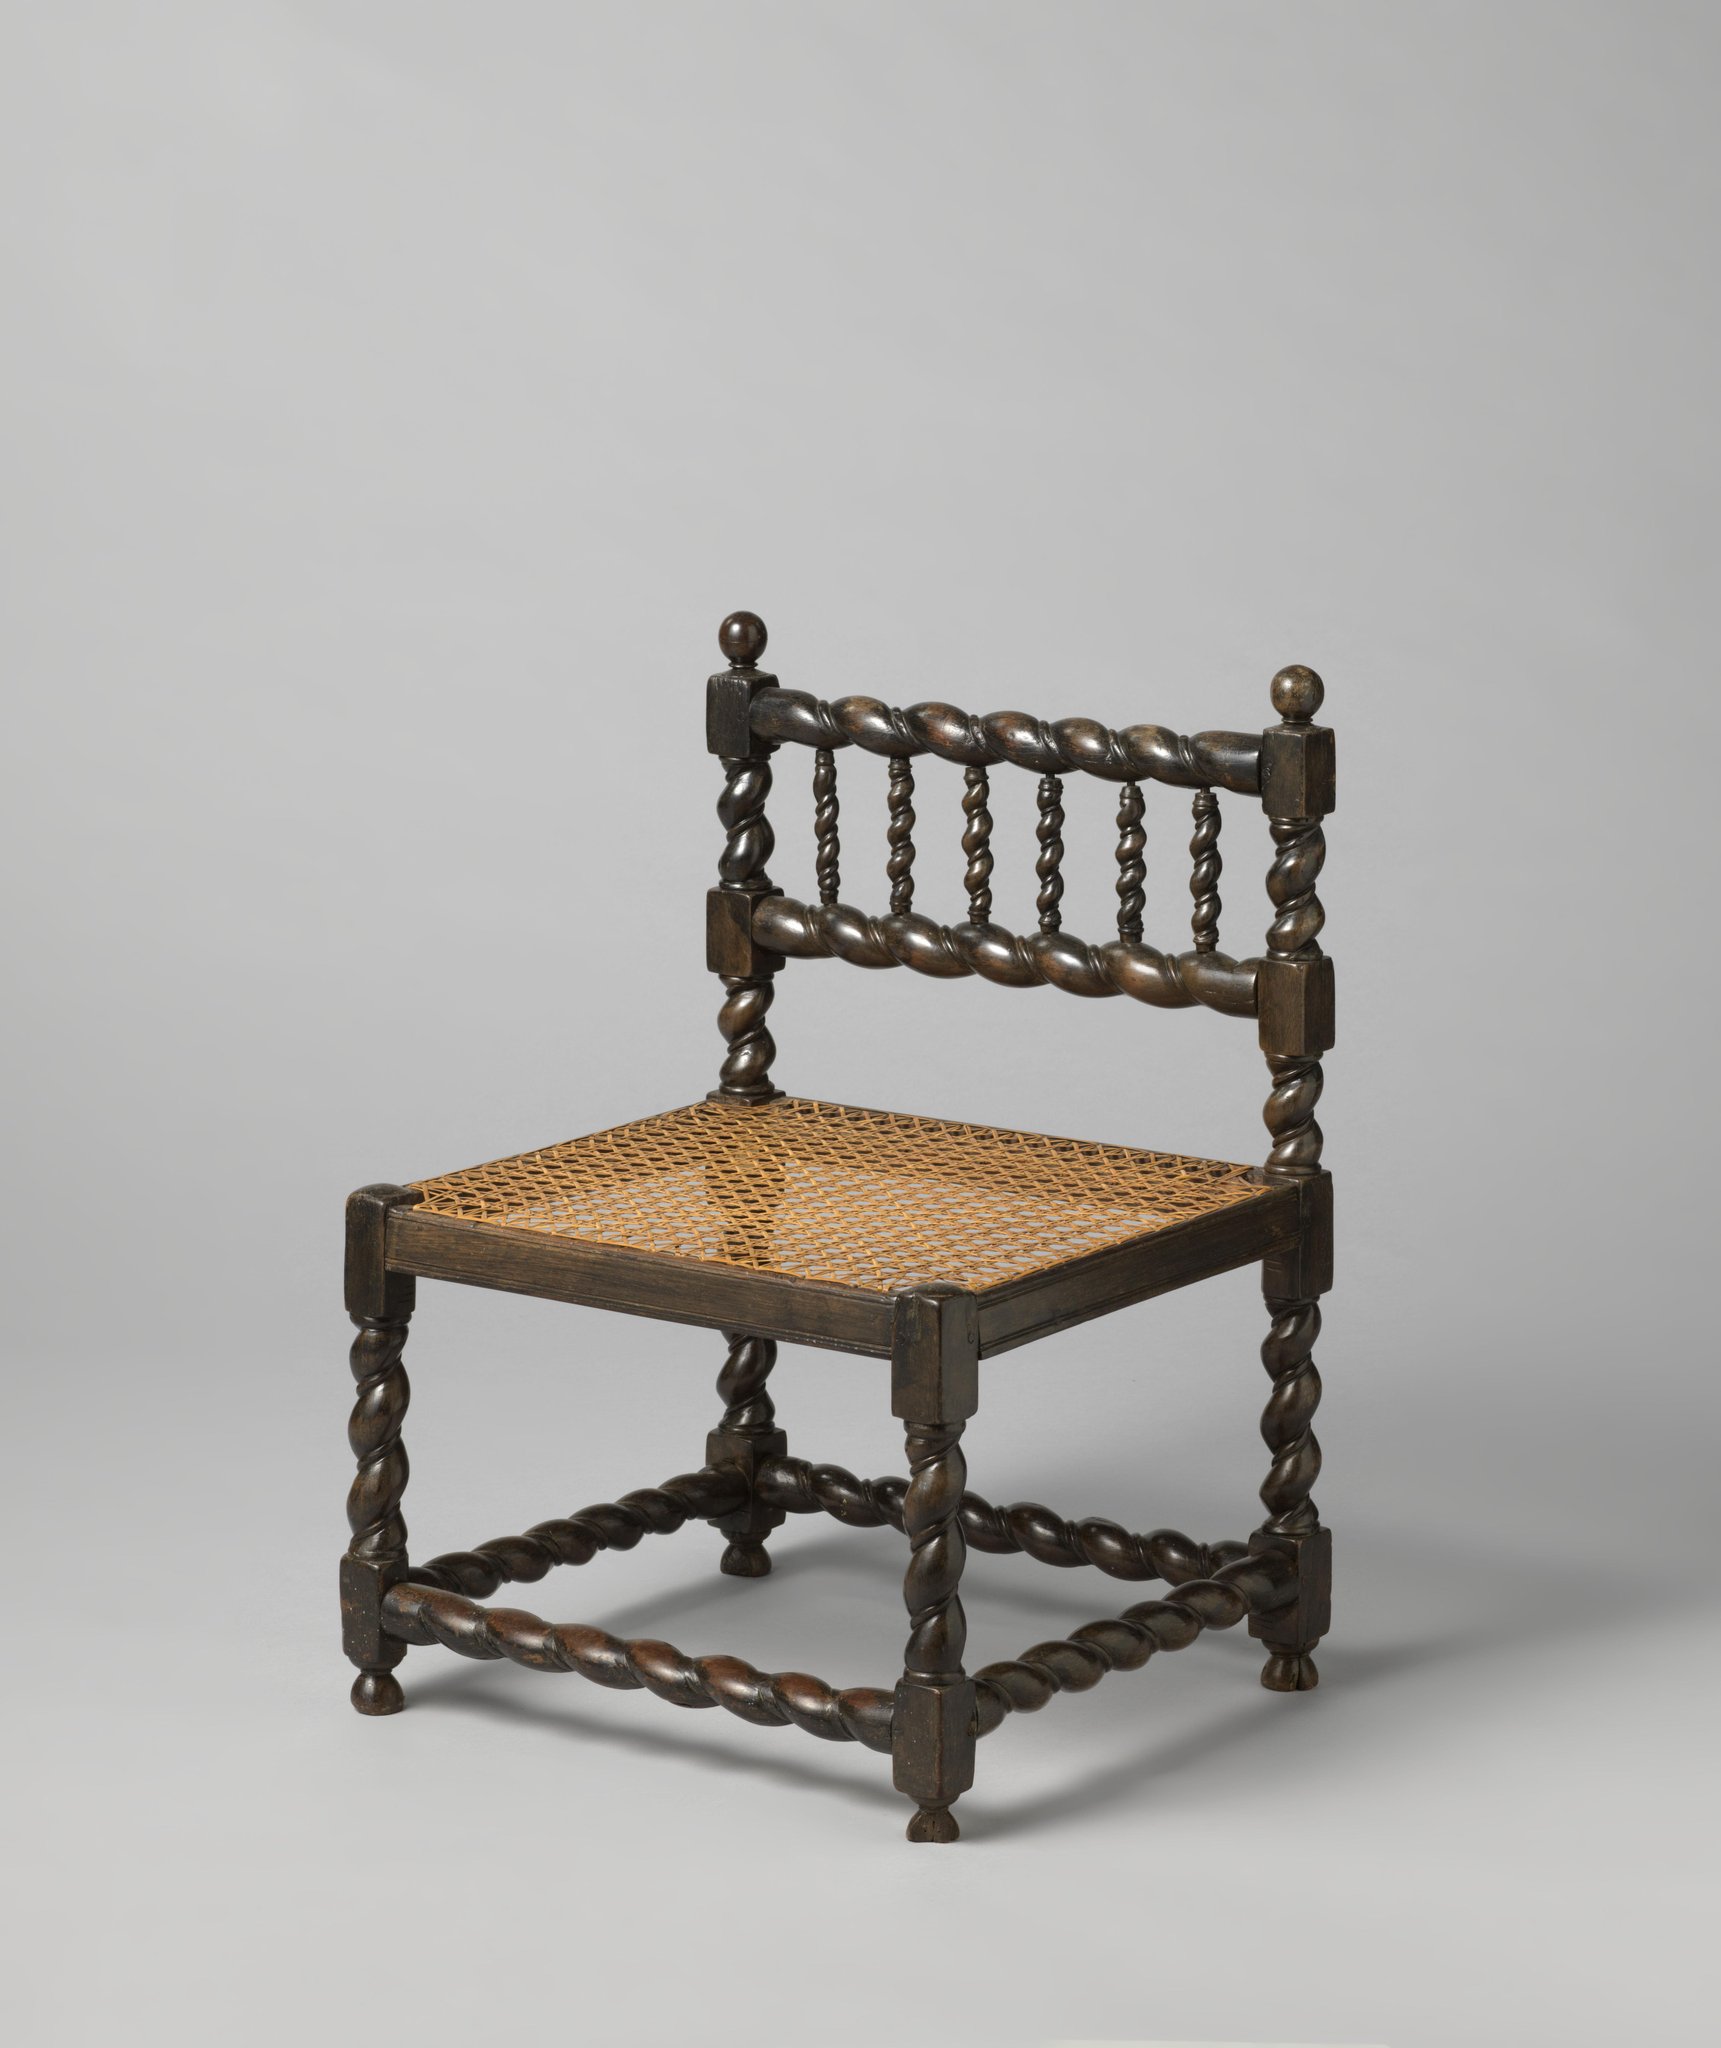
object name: chair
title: Stoel van ebbenhout en met riet bespannen zitting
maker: Anonymous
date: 1650-1699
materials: wood, rattan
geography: ambon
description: Chair. Ebony, cane. Indonesia, 1650 - 1700. Purchased from Stichting Cultuurgeschiedenis Nederlanders Overzee.